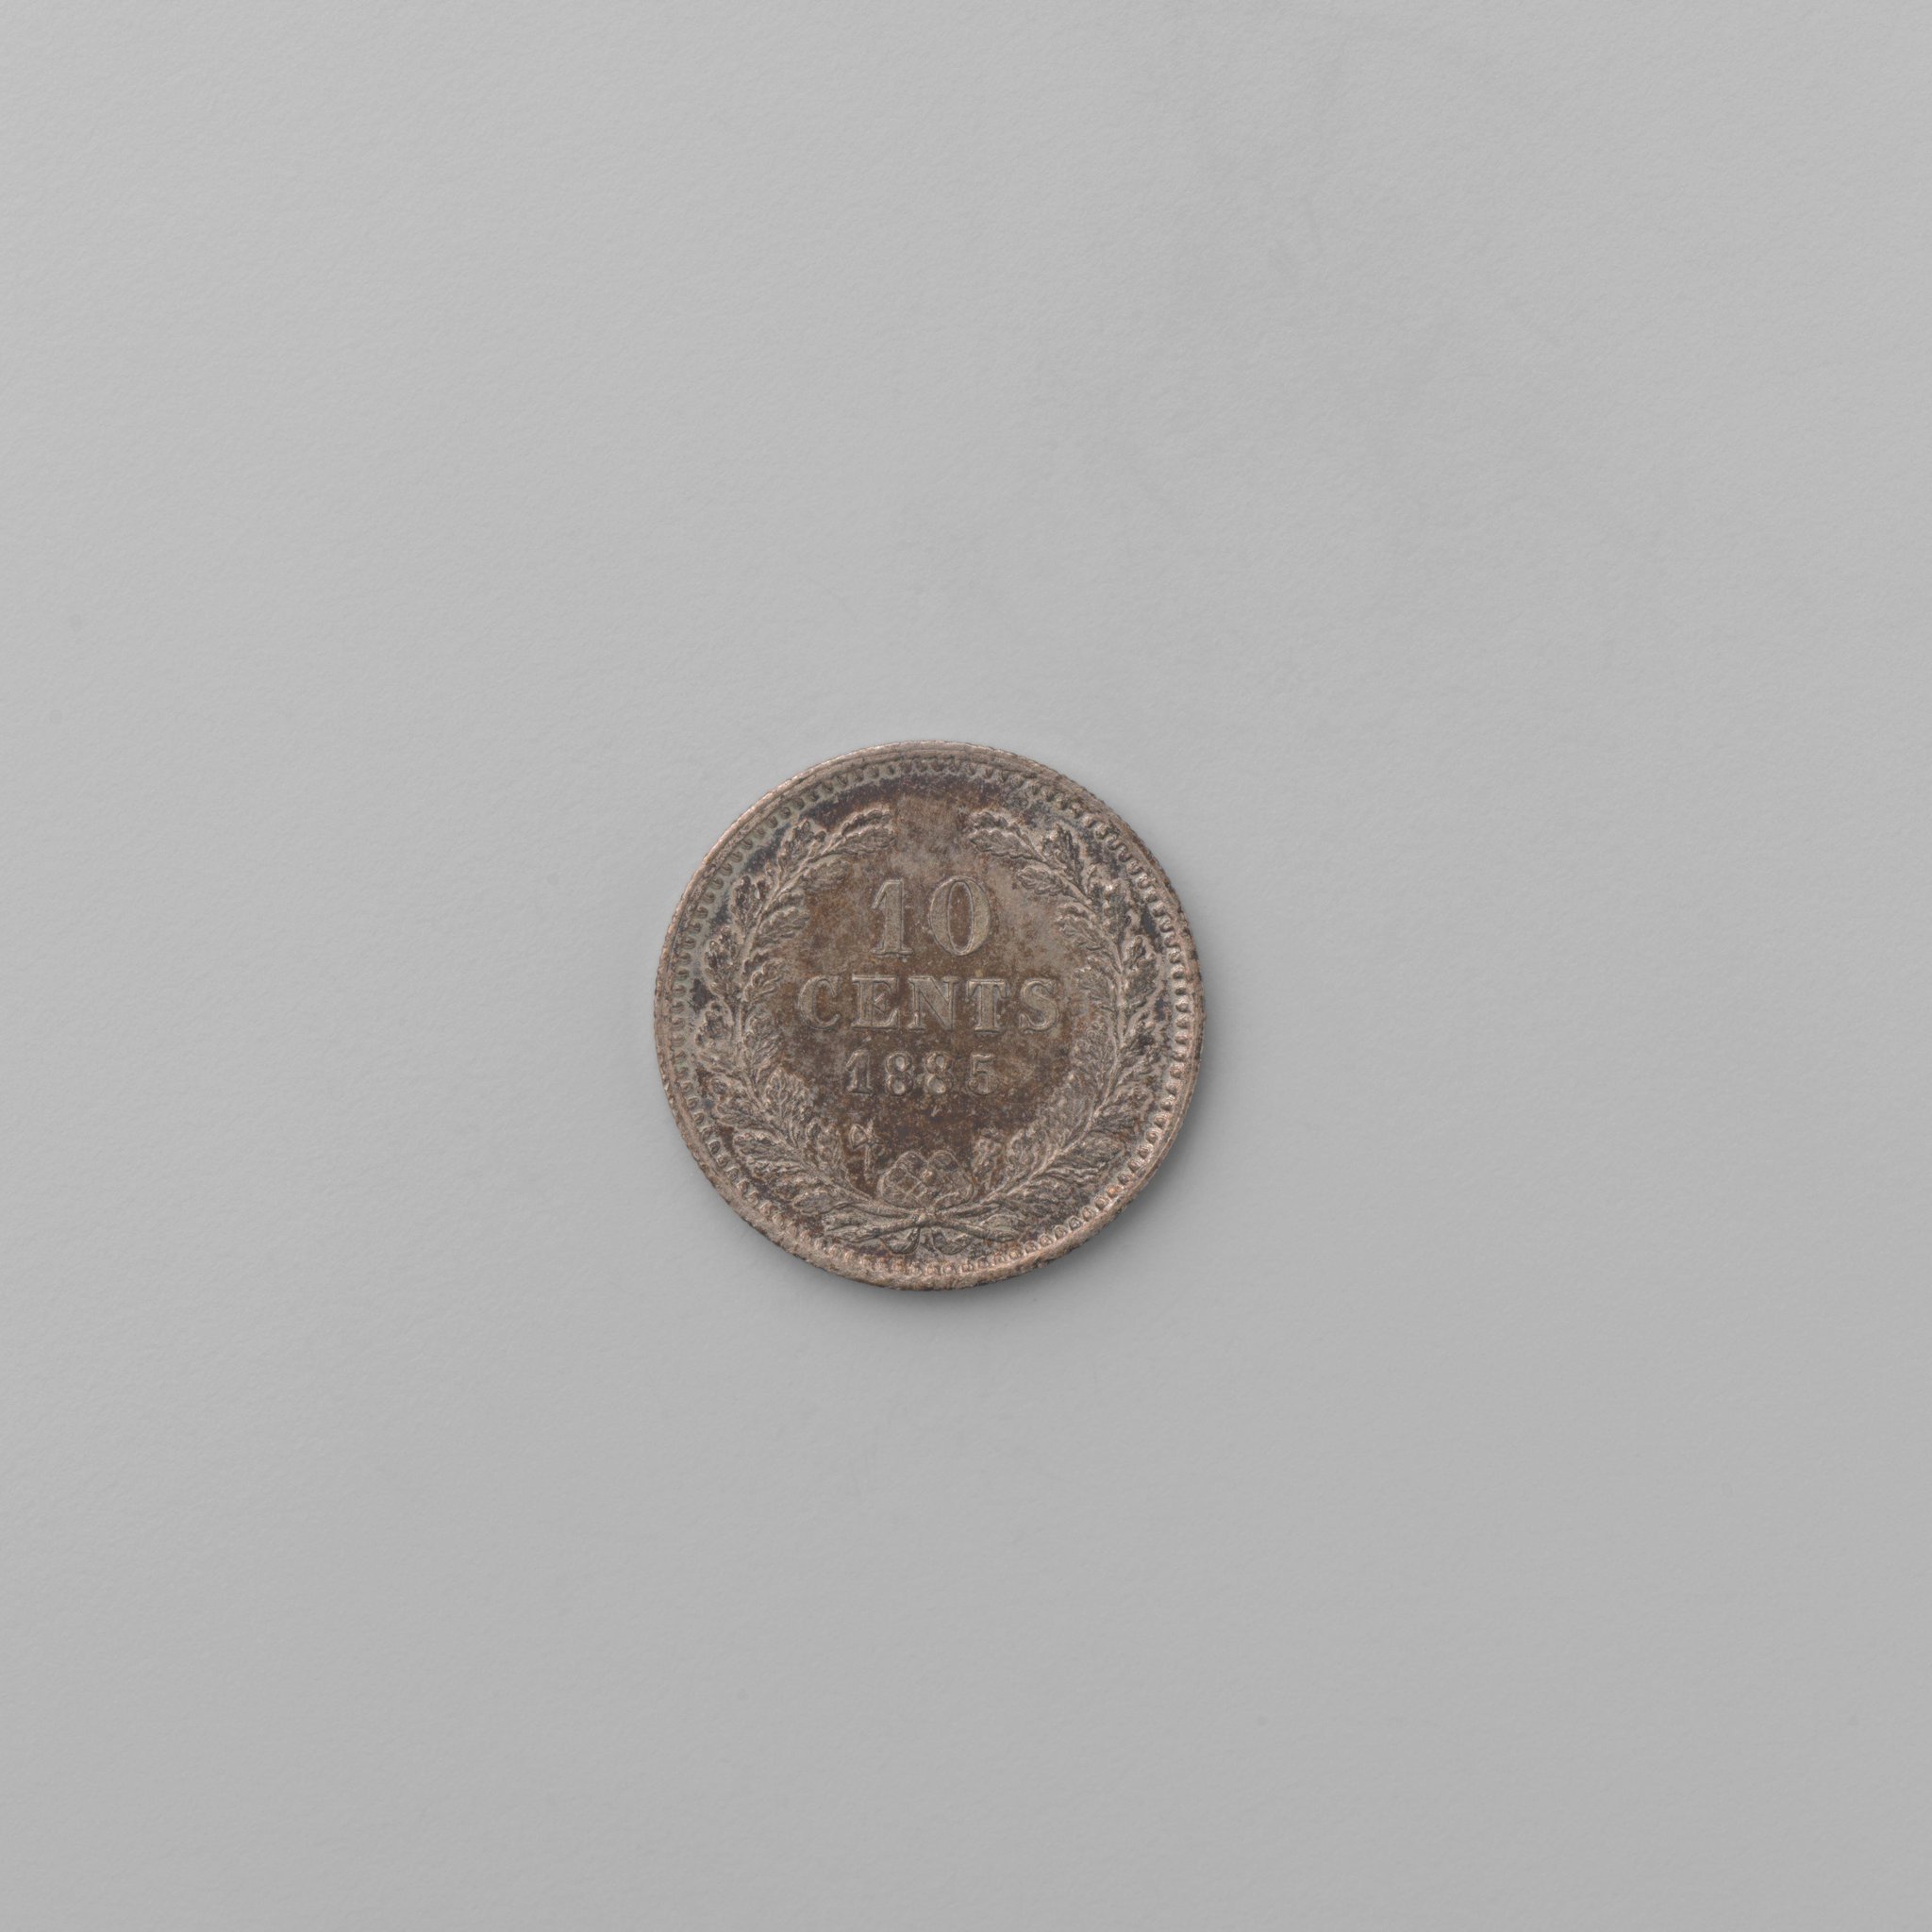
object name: coin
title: Nederland, 10 cent, 1885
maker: willem iii (koning der nederlanden)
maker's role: koning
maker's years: 1817-1890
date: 1885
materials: silver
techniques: striking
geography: utrecht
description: Zilveren munt. Voorzijde: borstbeeld naar rechts. Keerzijde: binnen twee samengebonden eiketakken waarde-aanduiding 10 cents en jaartal. Kartelrand.